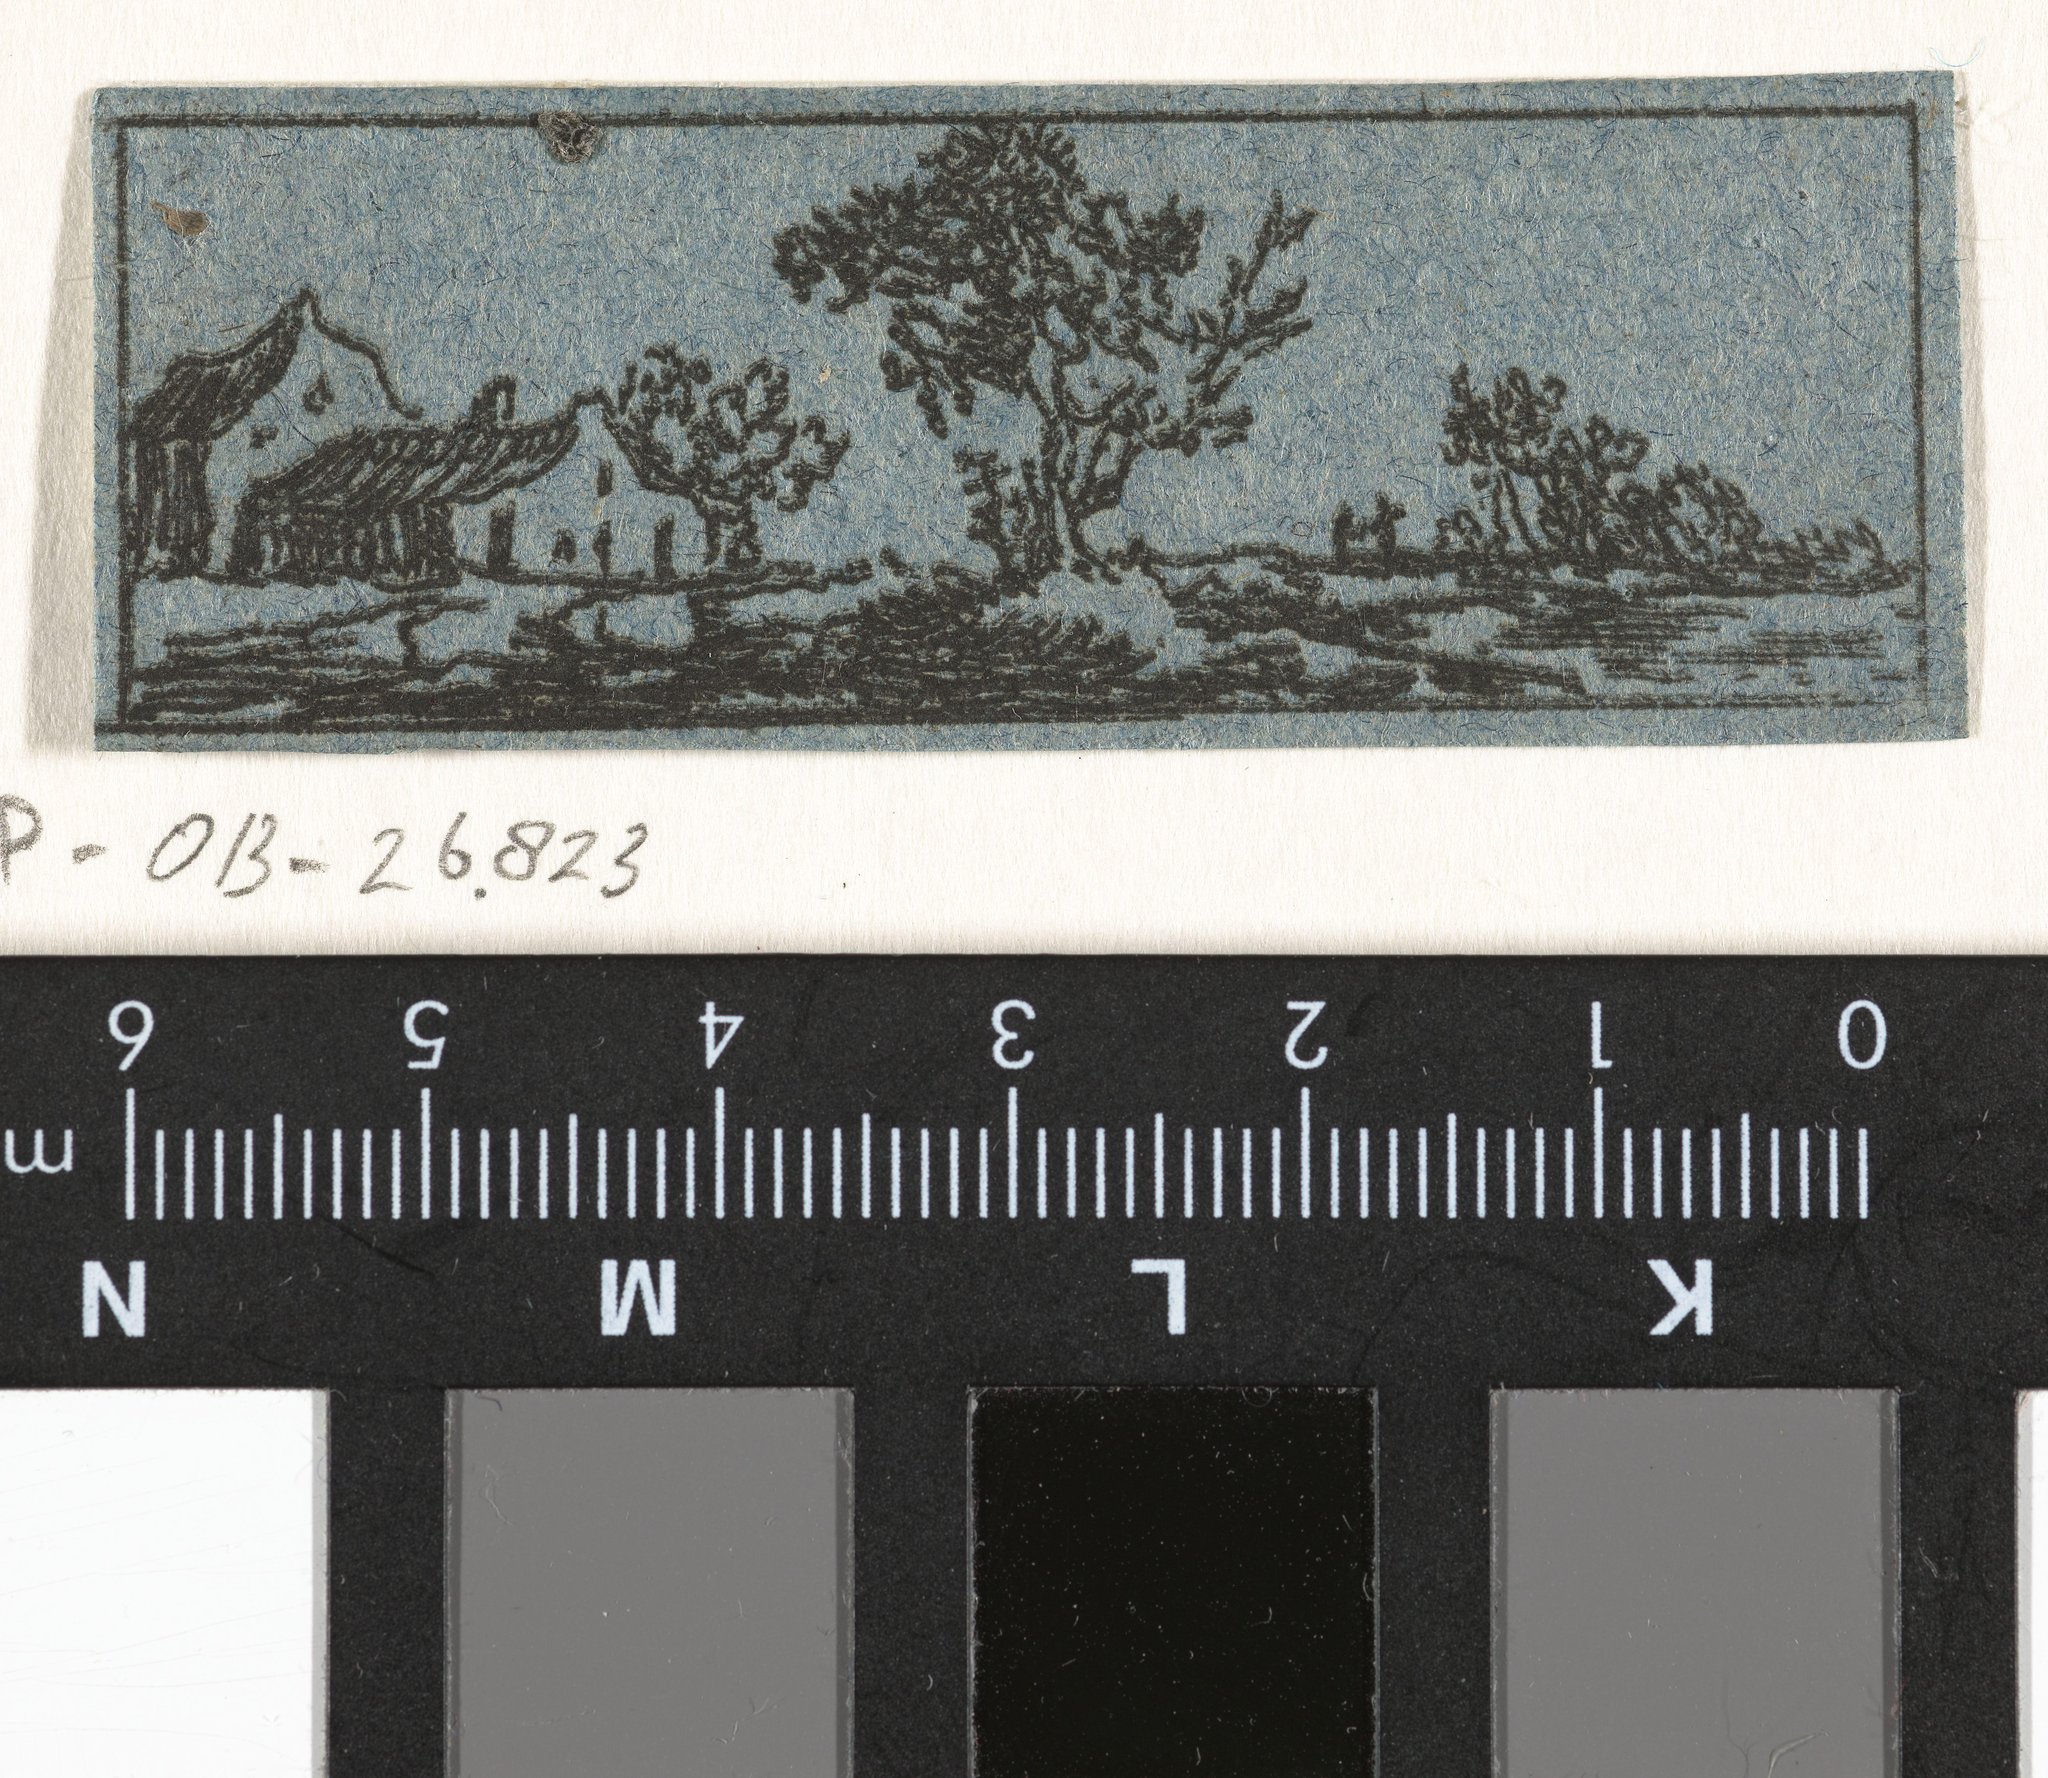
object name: print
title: Landschap met boerderij en grote boom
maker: anthonie van den bos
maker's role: draughtsman, print maker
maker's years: 1763-1838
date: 1778-1838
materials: paper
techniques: etching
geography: netherlands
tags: landscapes in the temperate zone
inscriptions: collector's mark: Lugt 2228